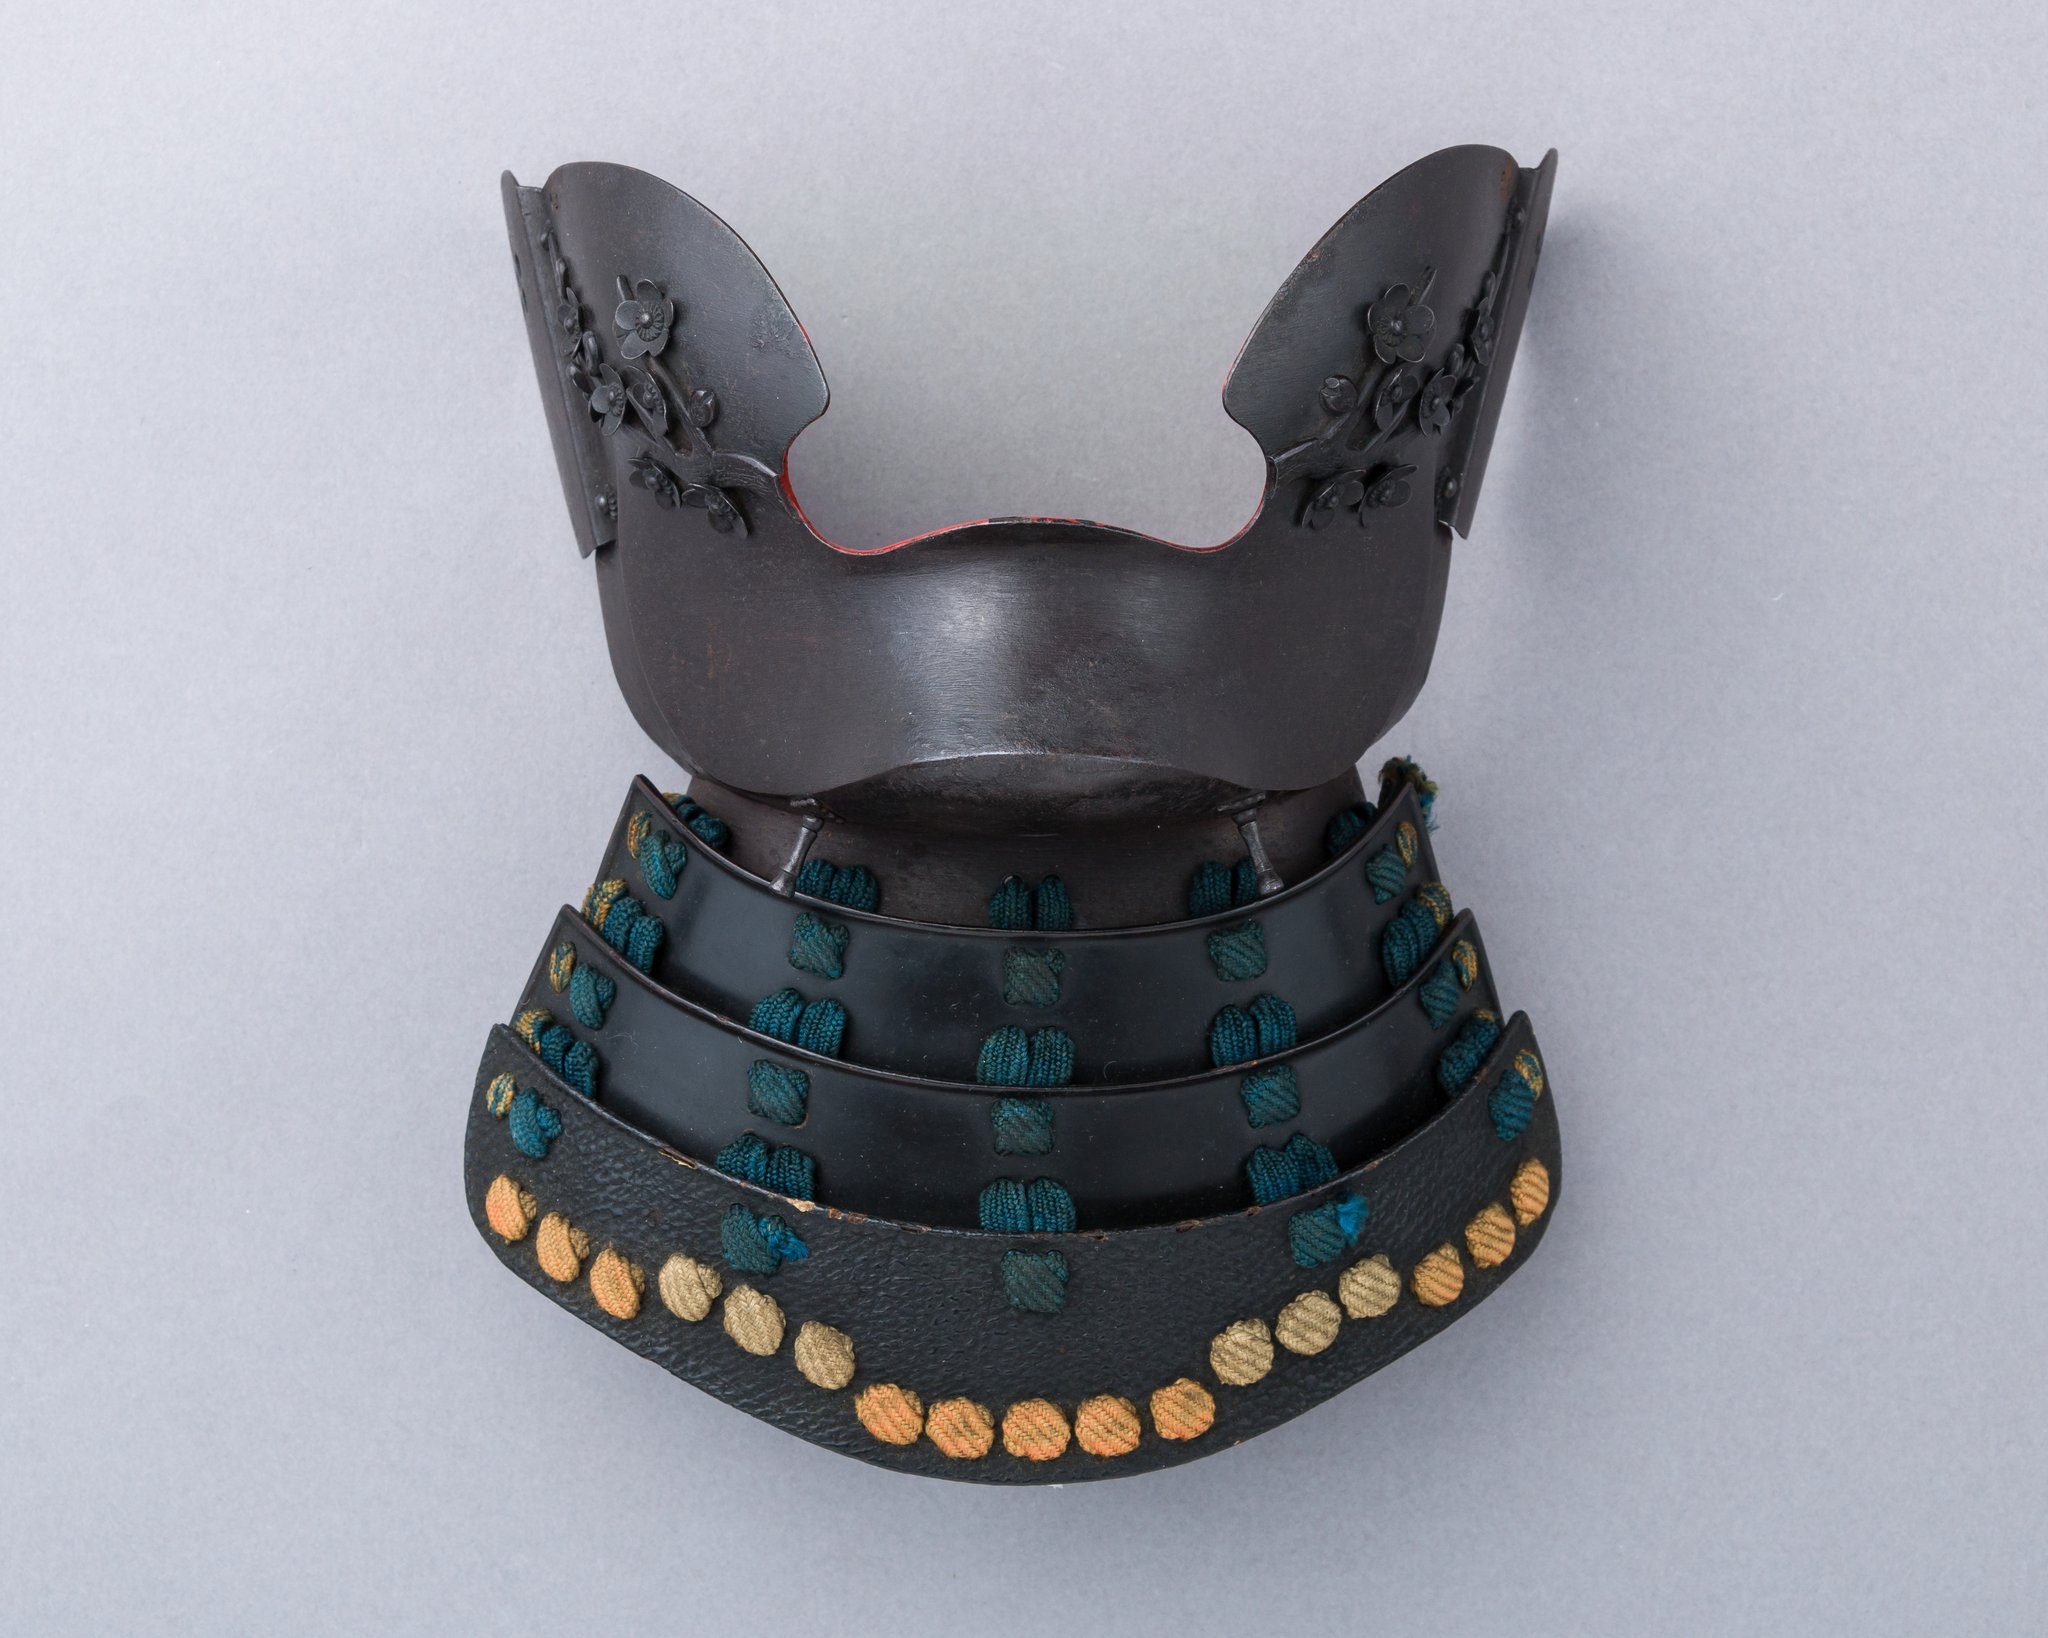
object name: mask for the lower face hanho ate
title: Mask for the Lower Face (Hanho-Ate)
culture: japanese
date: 1767-1833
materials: iron, lacquer, textile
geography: japan